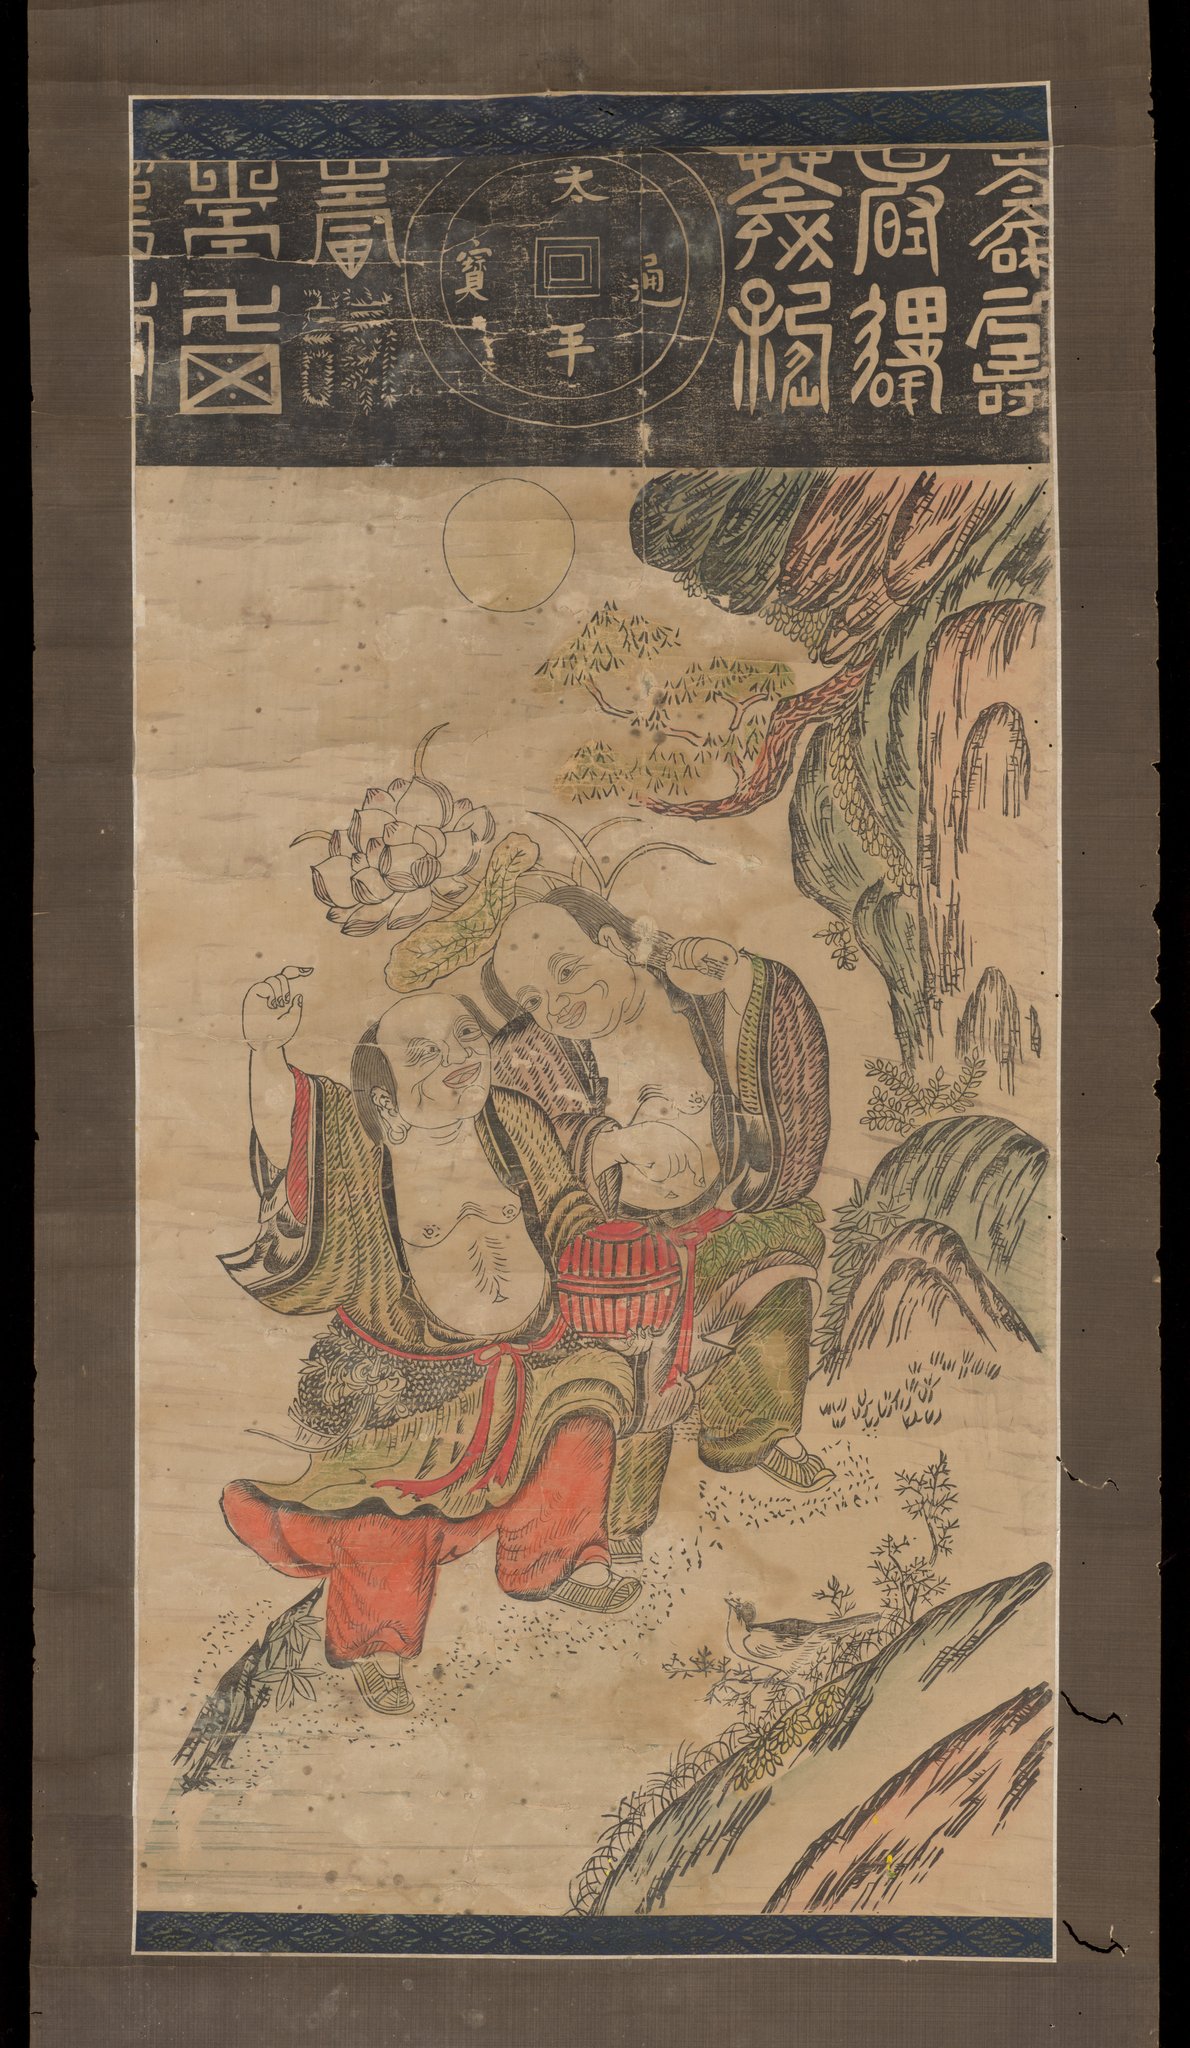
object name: print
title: The Two Immortals of Harmony and Unity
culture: chinese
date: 1736-1795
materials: ink, paper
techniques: hand coloring, woodblock print